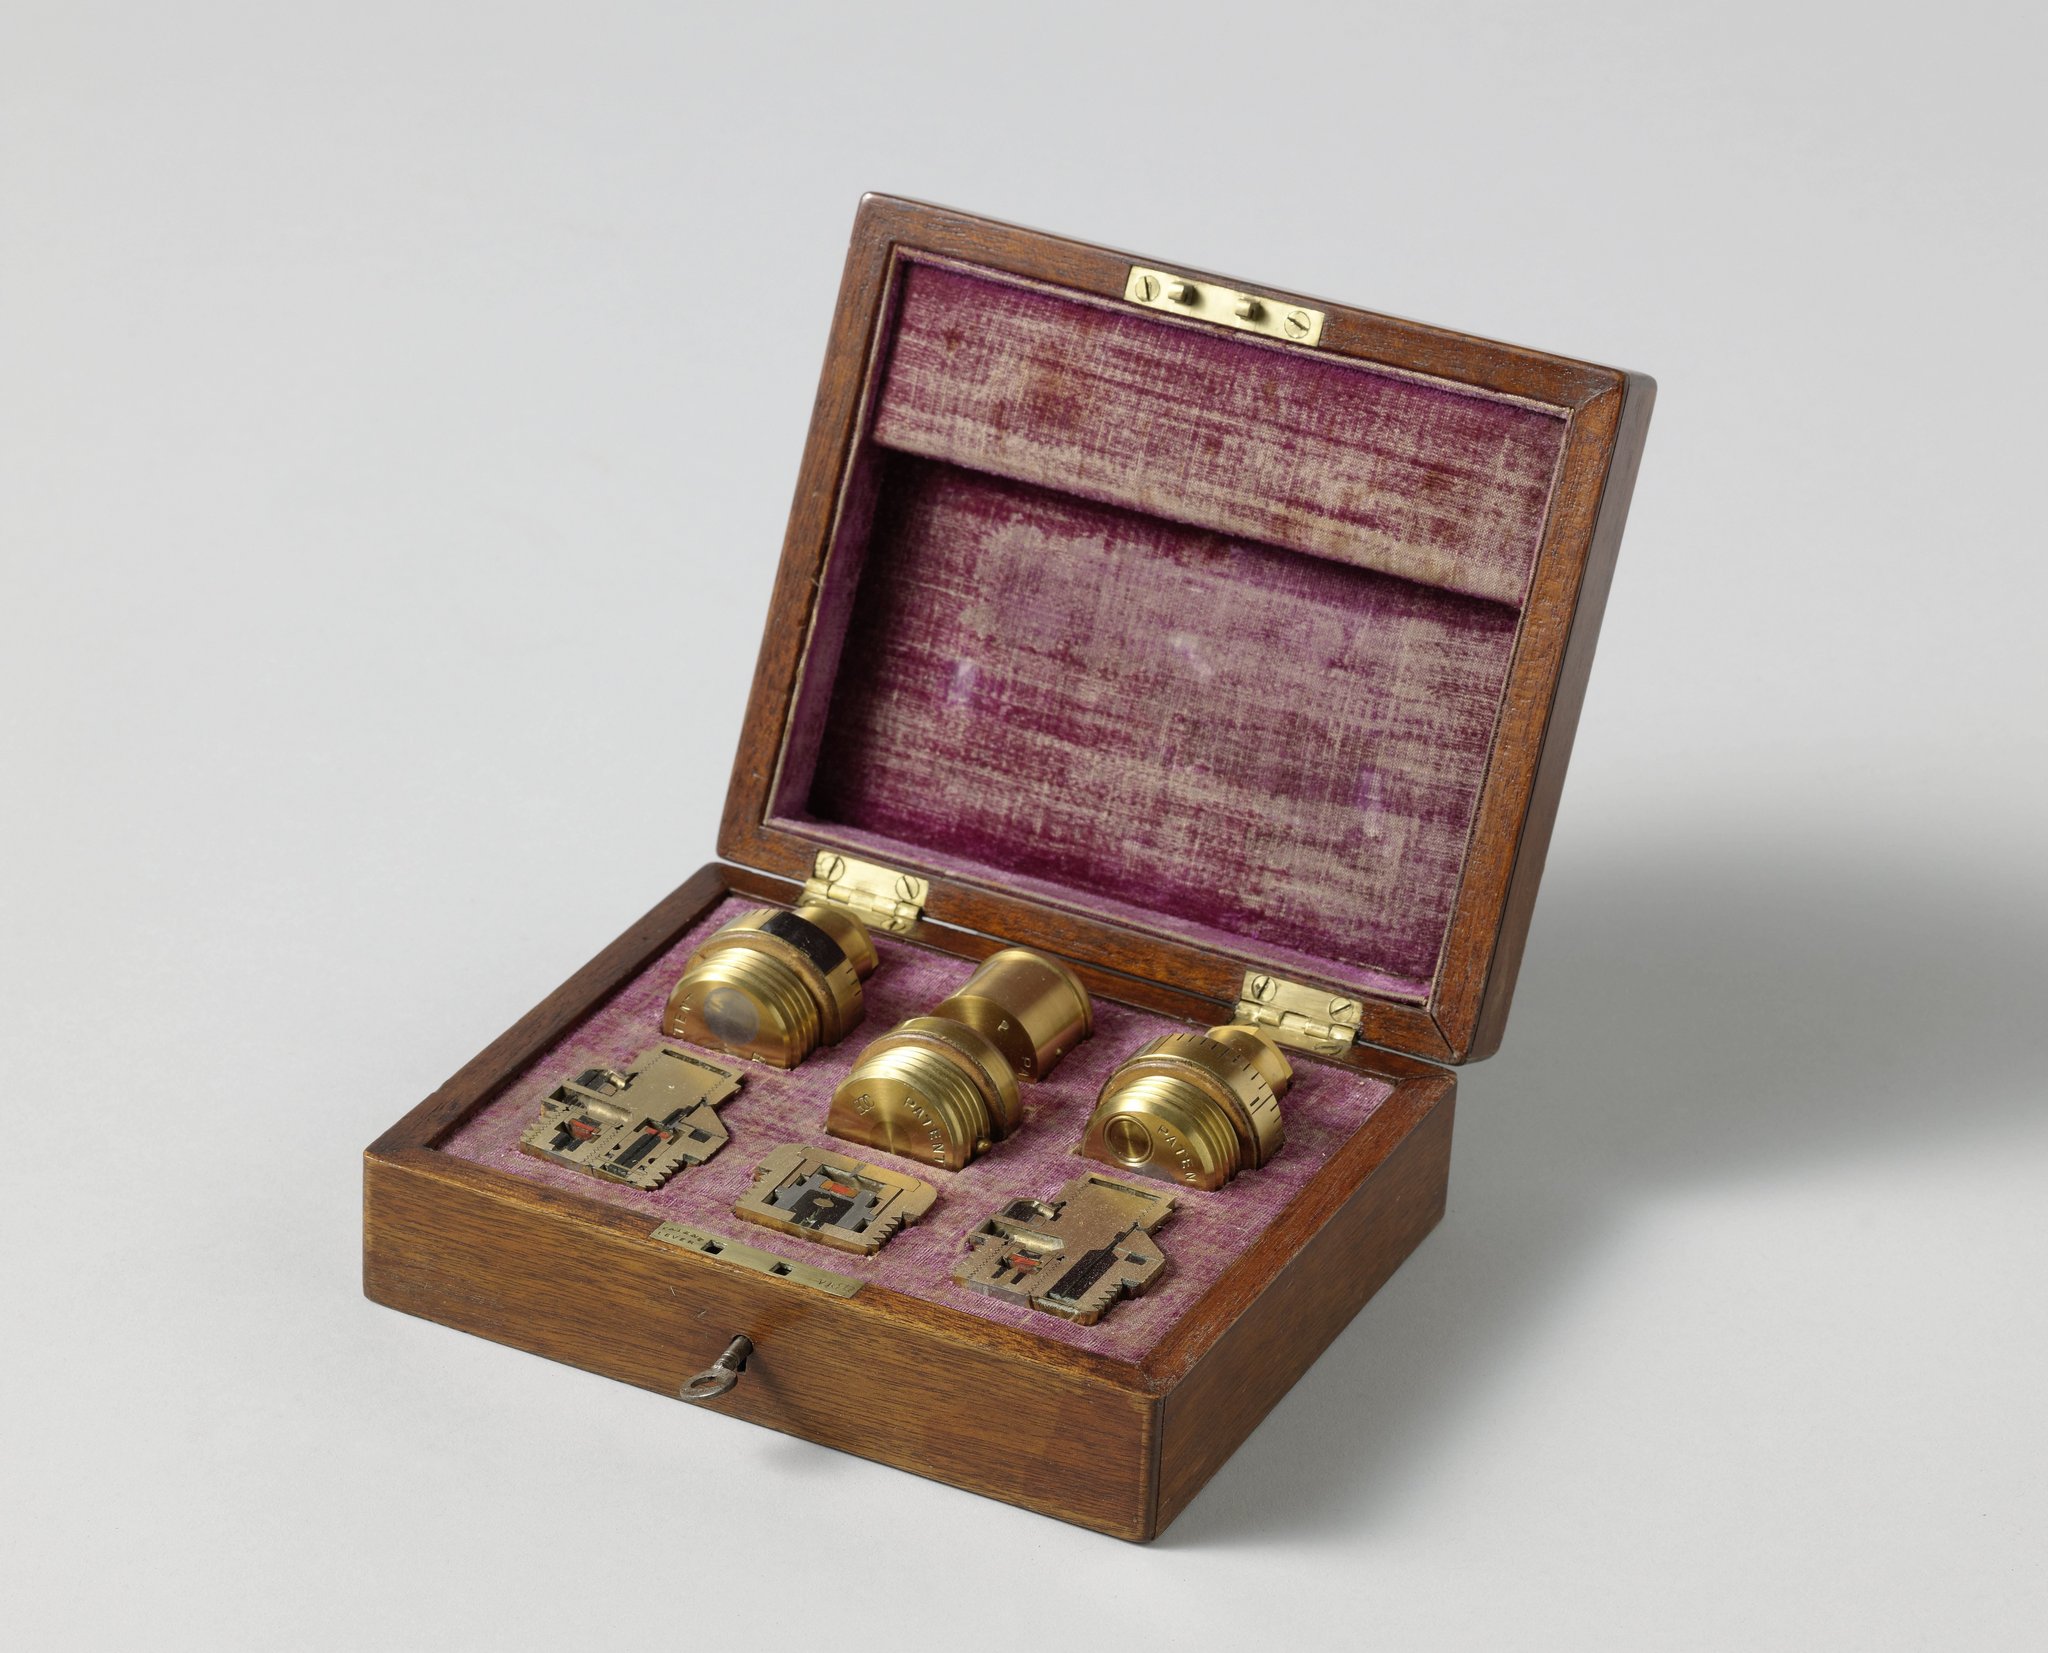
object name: demonstration model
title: Box with Seven Shell Fuses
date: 1867-1872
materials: brass, iron, leather, velvet, wood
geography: woolwich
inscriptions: inscription, on each fuse: ‘BOC; PATENT’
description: Klein houten kistje met zeven granaatbuizen voor puntgranaten. Drie buizen zijn dubbel, eenmaal heel, eenmaal een helft van een overlangs doorgesneden buis. Deze drie paren stellen de volgende buizen voor: de Field service time-fuse (Armstrong buis type E), de Field service time and concussion-fuse (Armstrong buis type F) en de Armstrong Plain field service concussion-fuse. De zevende buis, zonder schroefdraad, is de Field service concussion-fuse (Armstrong buis type C), die in combinatie met type E gebruikt kon worden.